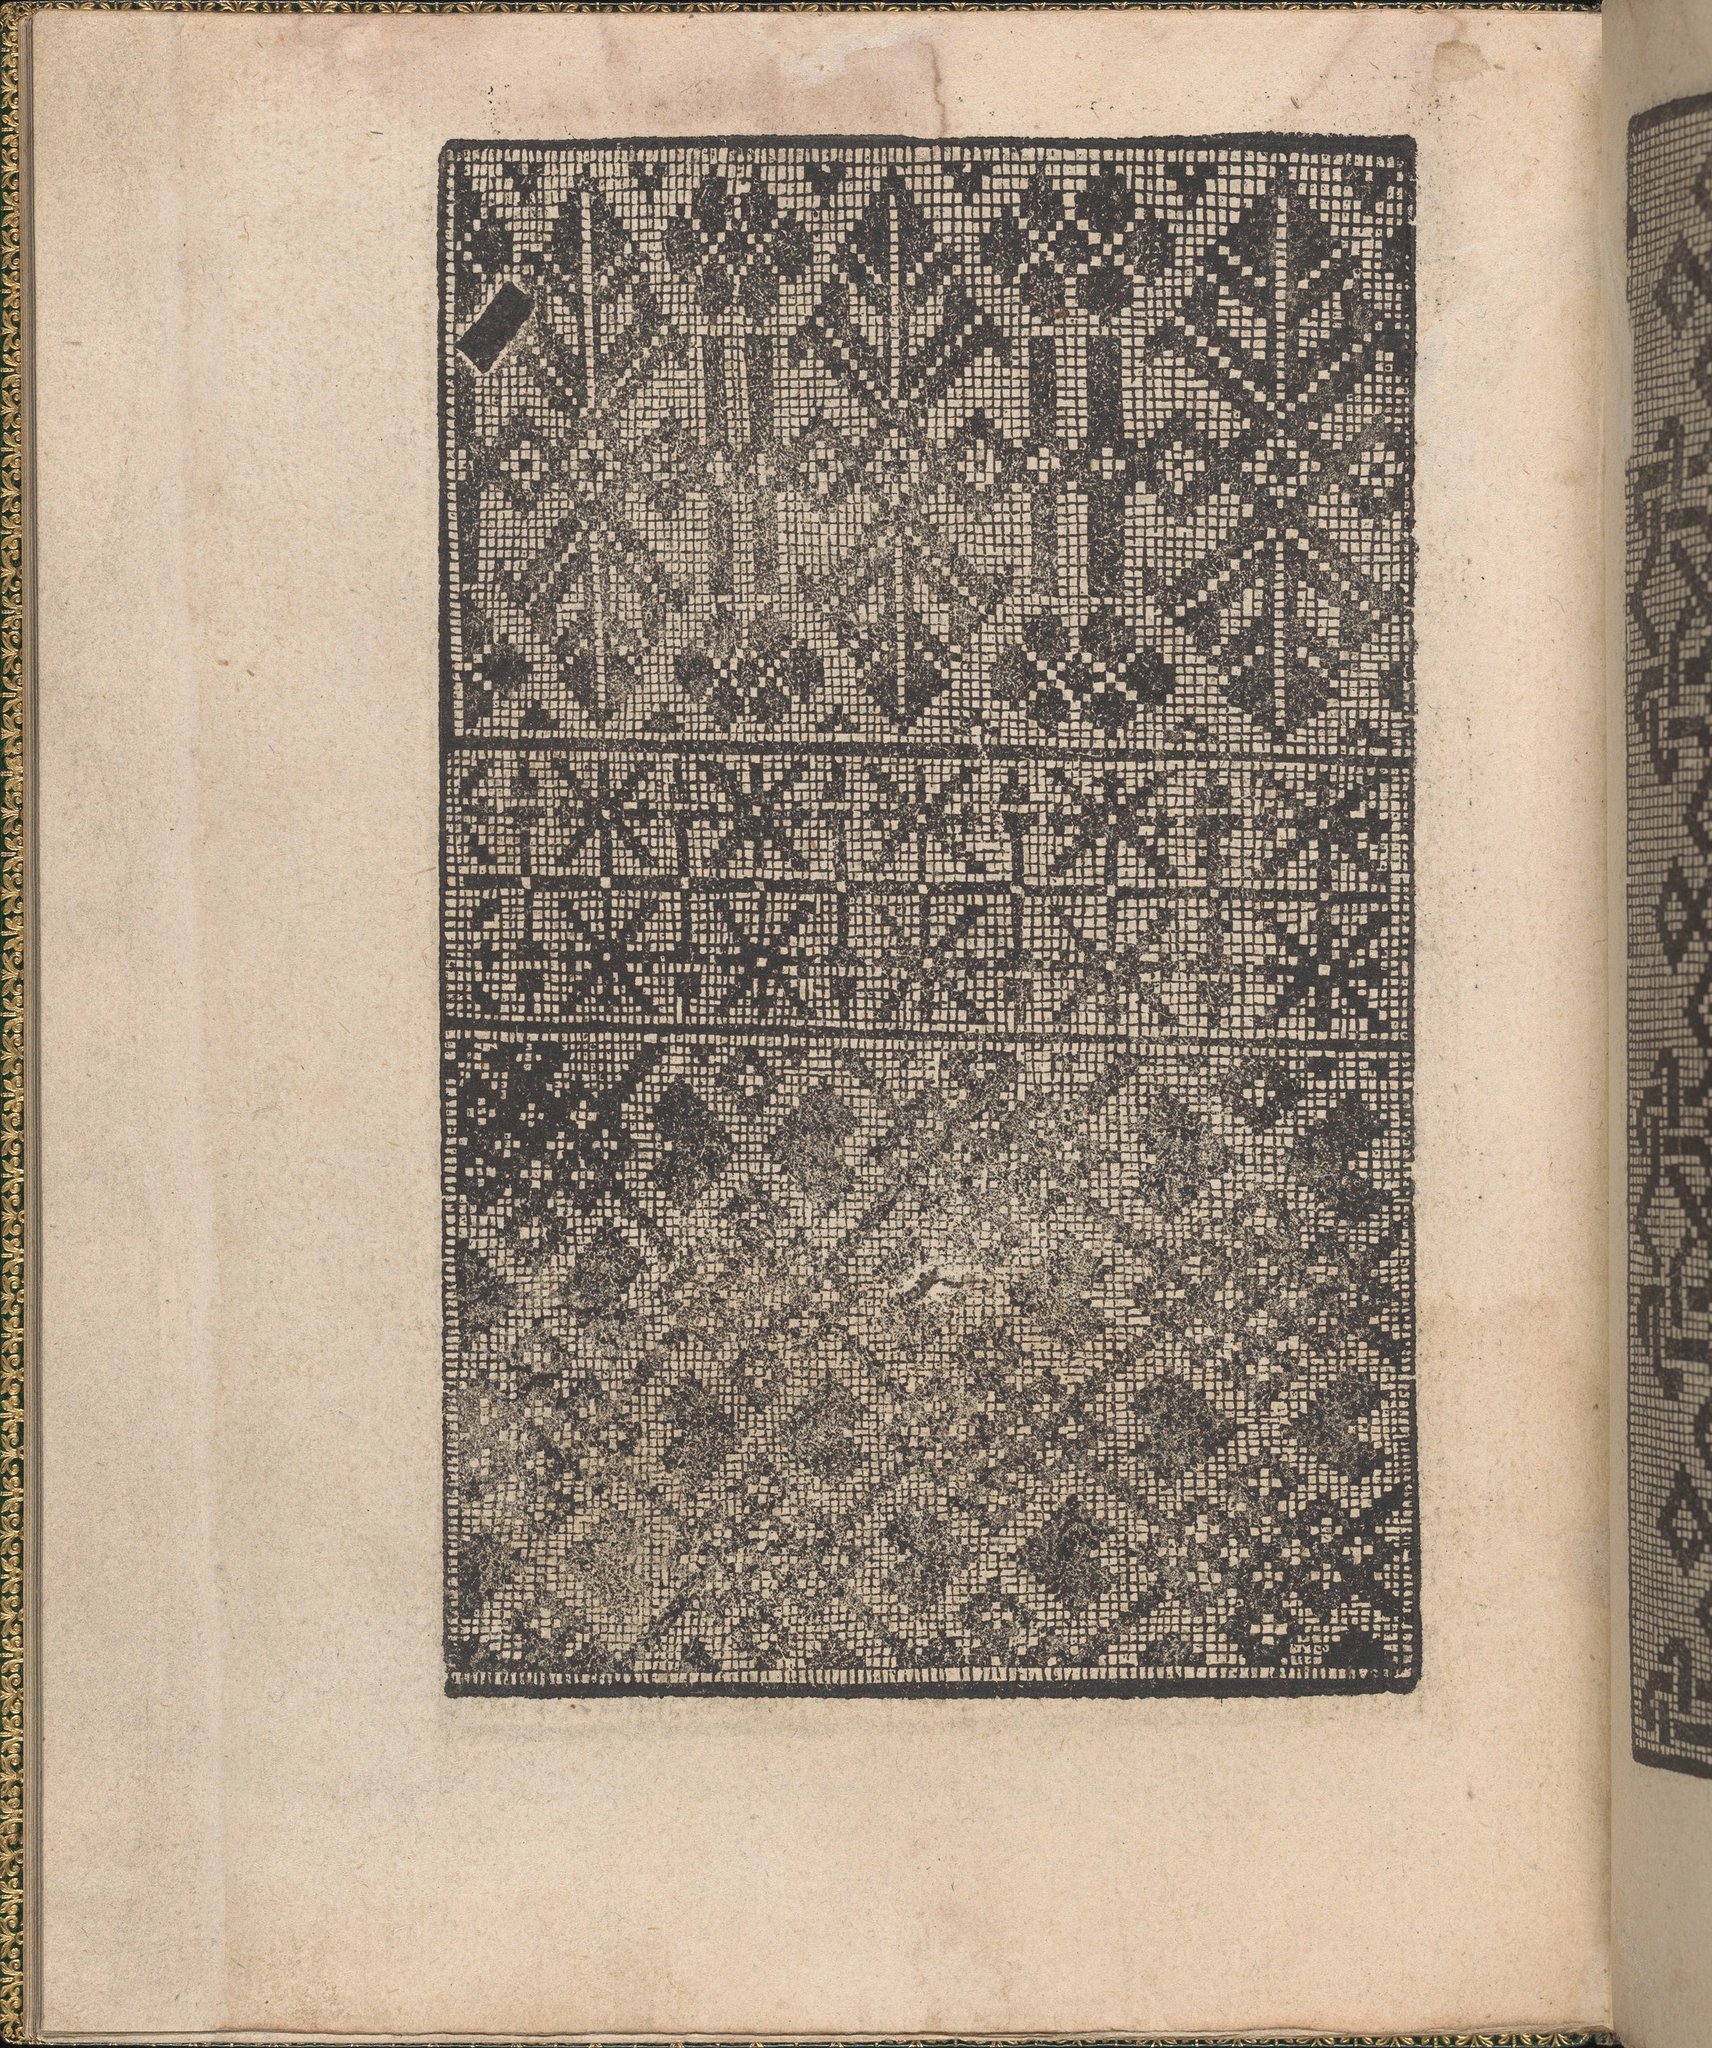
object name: book print ornament architecture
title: Ornamento delle belle & virtuose donne, page 22 (verso)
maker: matteo pagano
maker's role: publisher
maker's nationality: italian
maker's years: 1515-1588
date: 1554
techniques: woodcut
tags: ornament